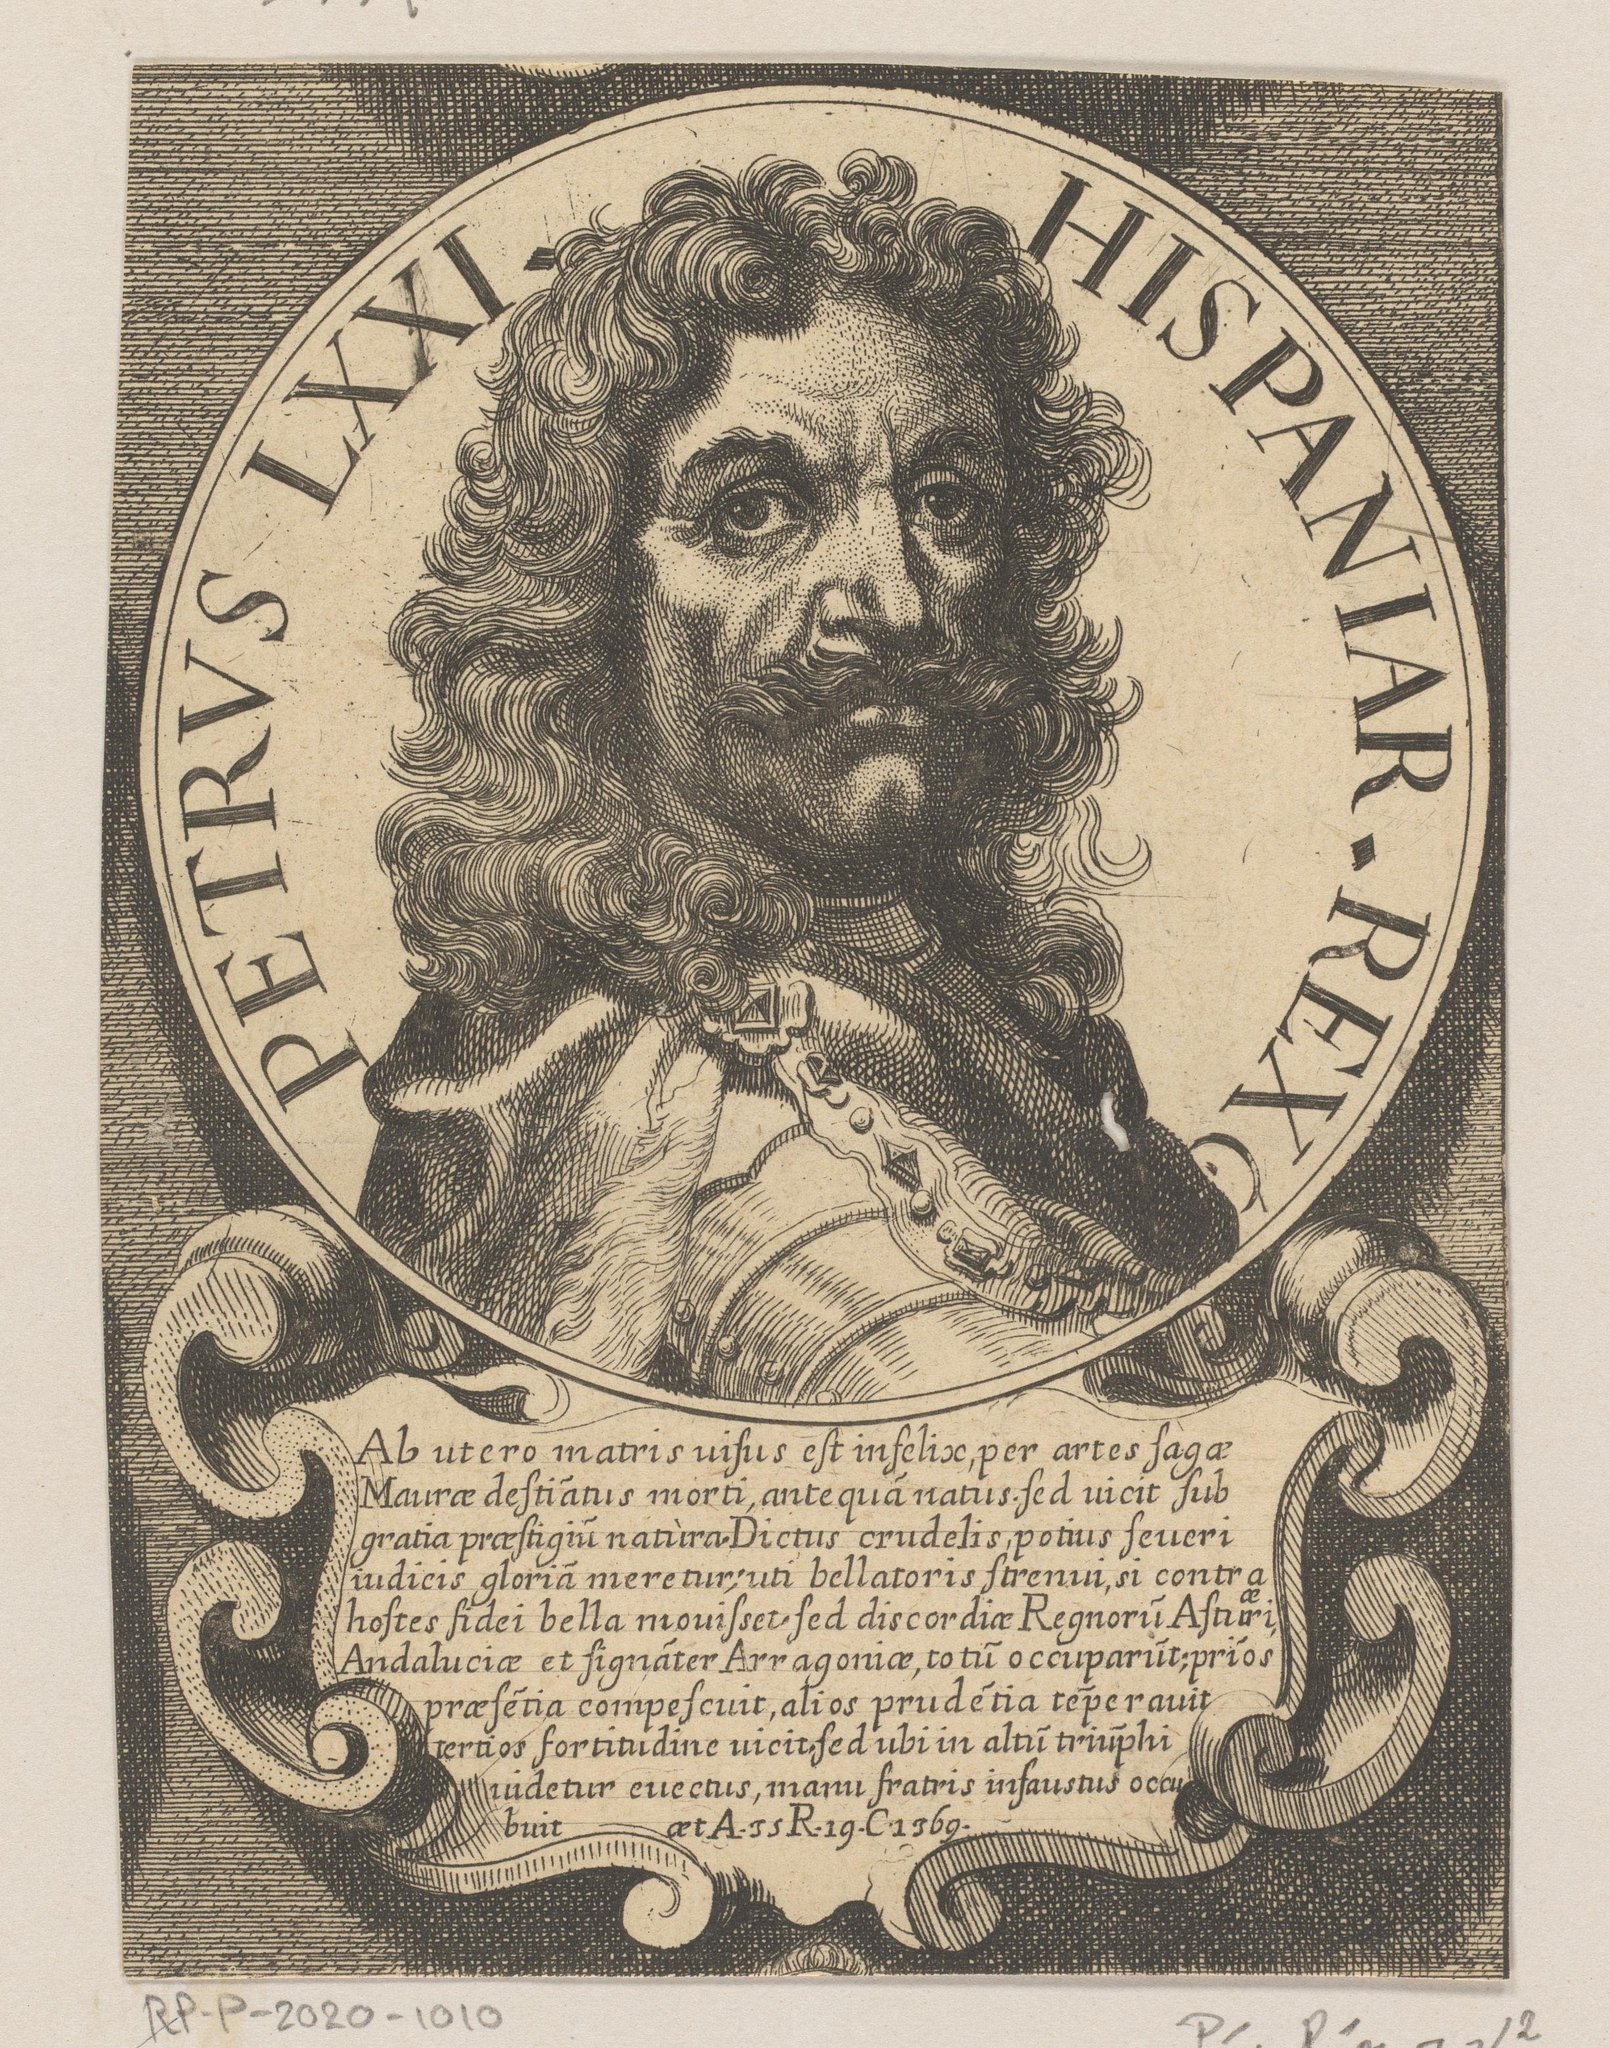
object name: print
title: Portret van Peter I, koning van Castilië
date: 1684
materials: paper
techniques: engraving, etching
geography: rome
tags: historical persons, ruler, sovereign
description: Portret mogelijk afkomstig van een grote prent, getiteld 'Effigies et series regum Hispaniae primum ex Gothis Christianorum (...)', bestaande uit meerdere bladen die samengevoegd konden worden, uitgegeven door Giovanni Giacomo de' Rossi in 1684.